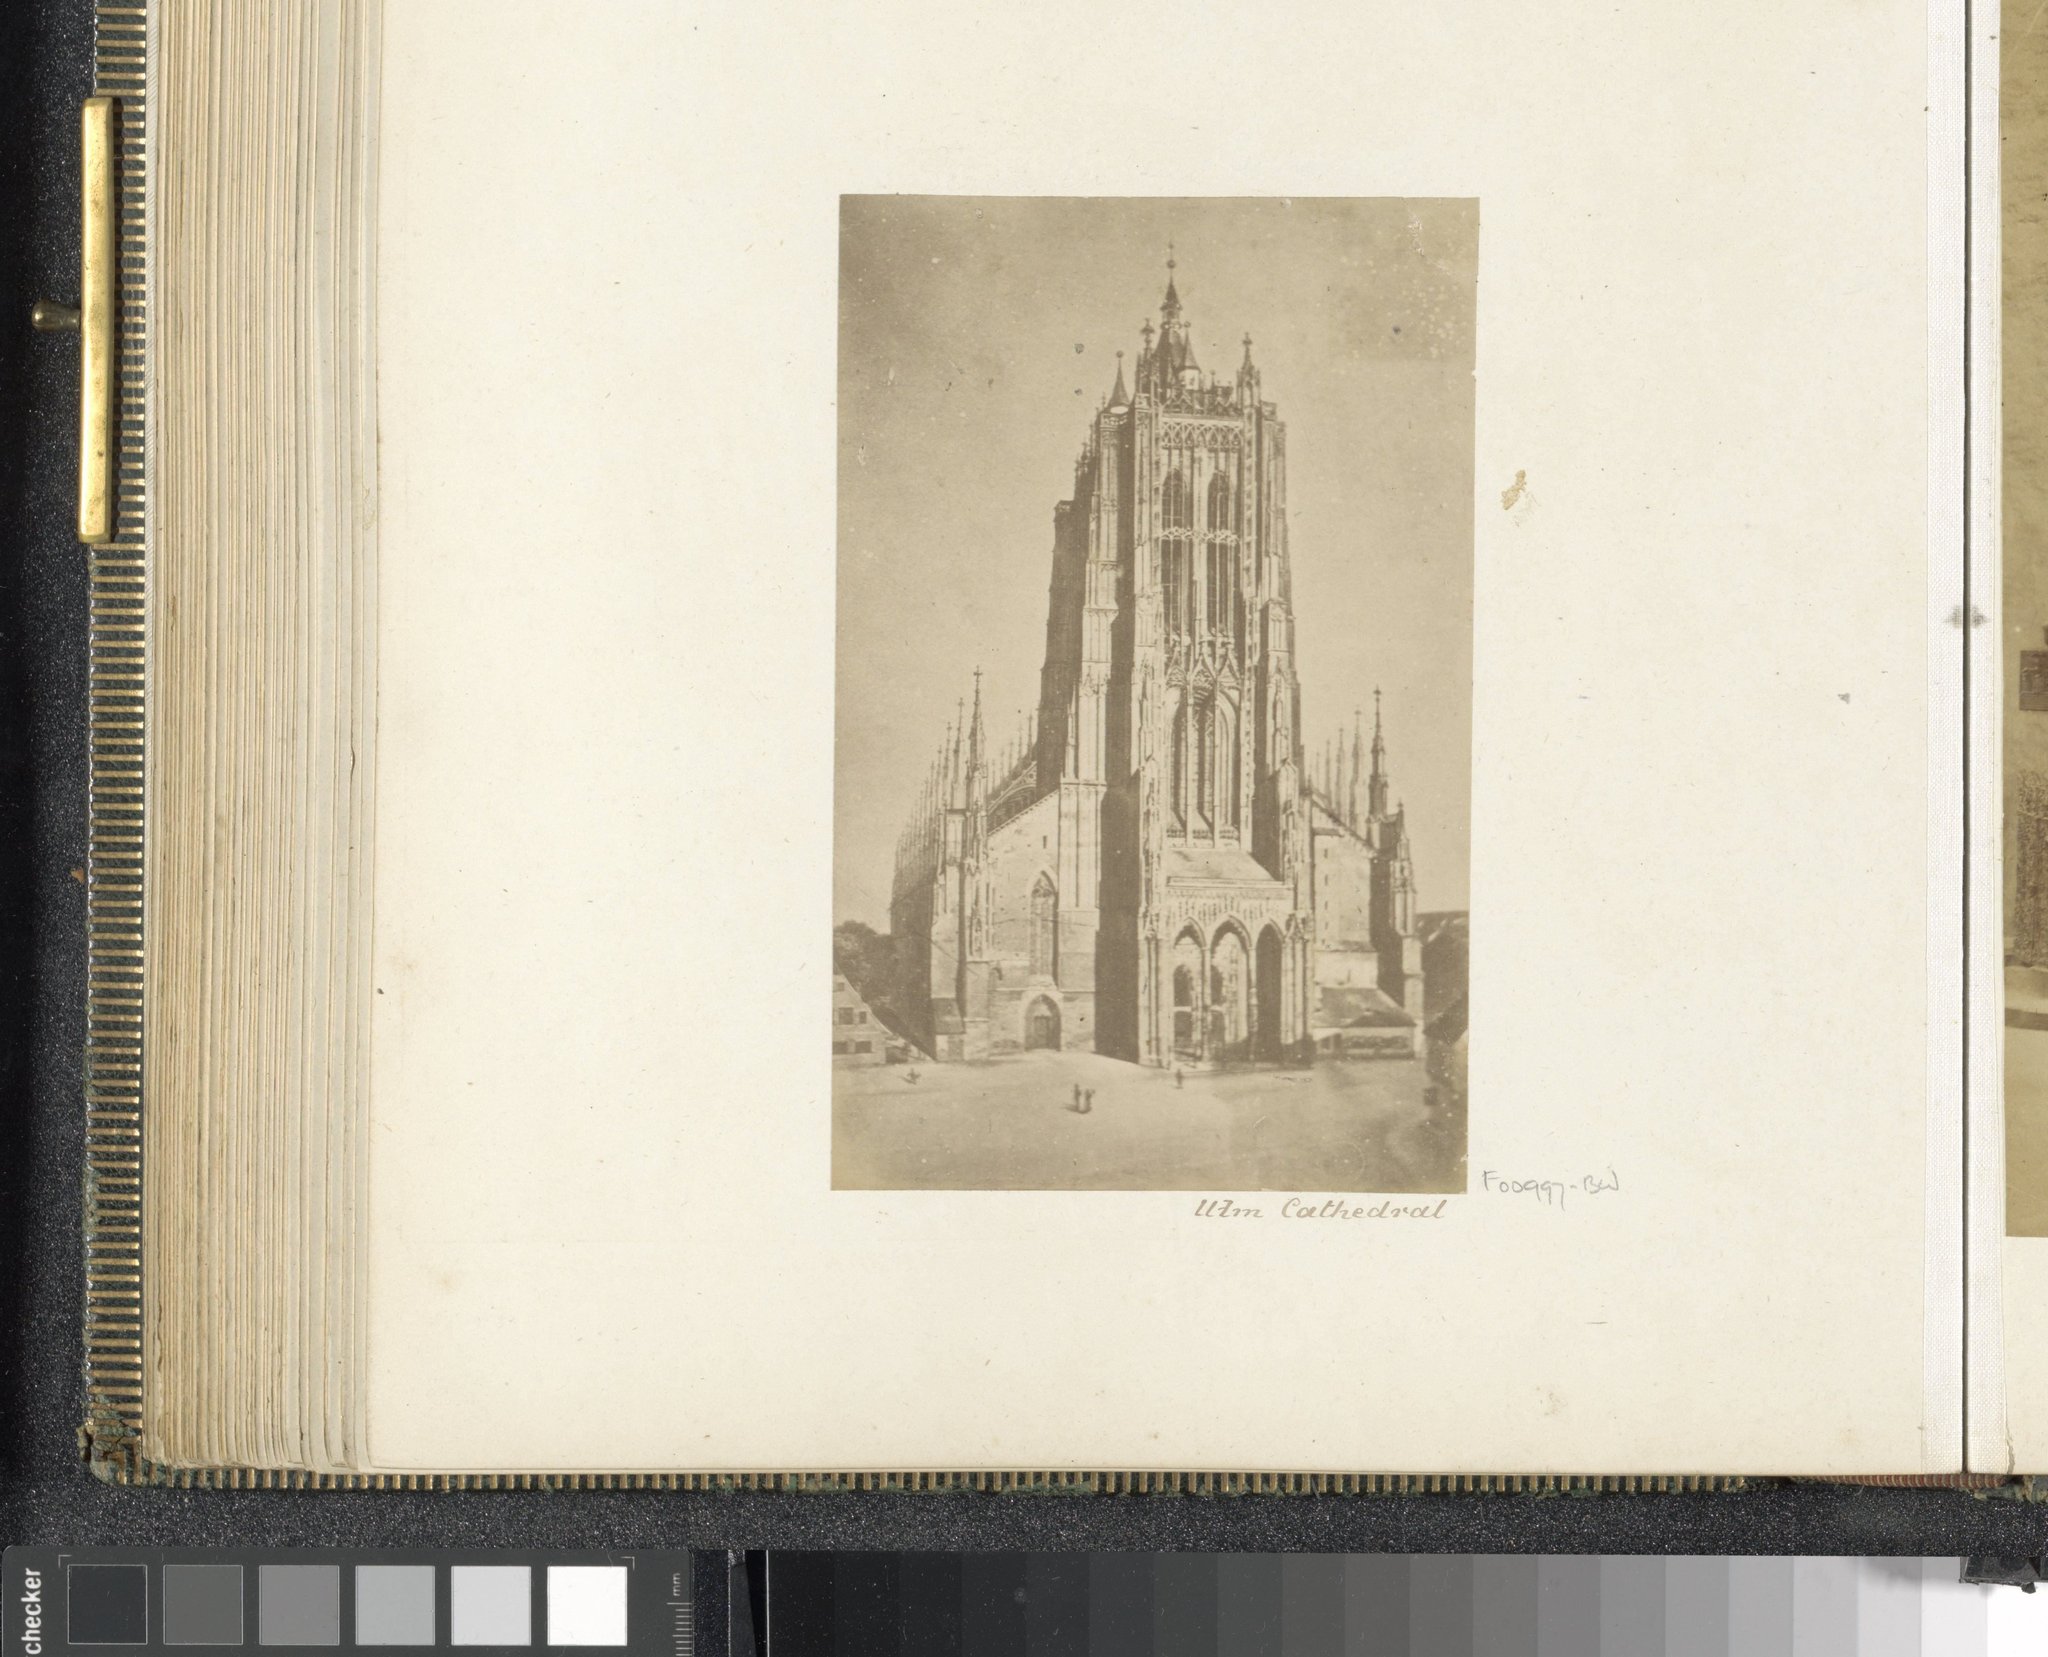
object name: photograph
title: Ulm Cathedral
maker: Anonymous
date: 1860-1890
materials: paper, photographic support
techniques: albumen print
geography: ulm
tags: gate, entrance, parts of church exterior and annexes: tower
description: Onderdeel van Reisalbum met foto's van Zwitserland, Oostenrijk, Italië en Duitsland.